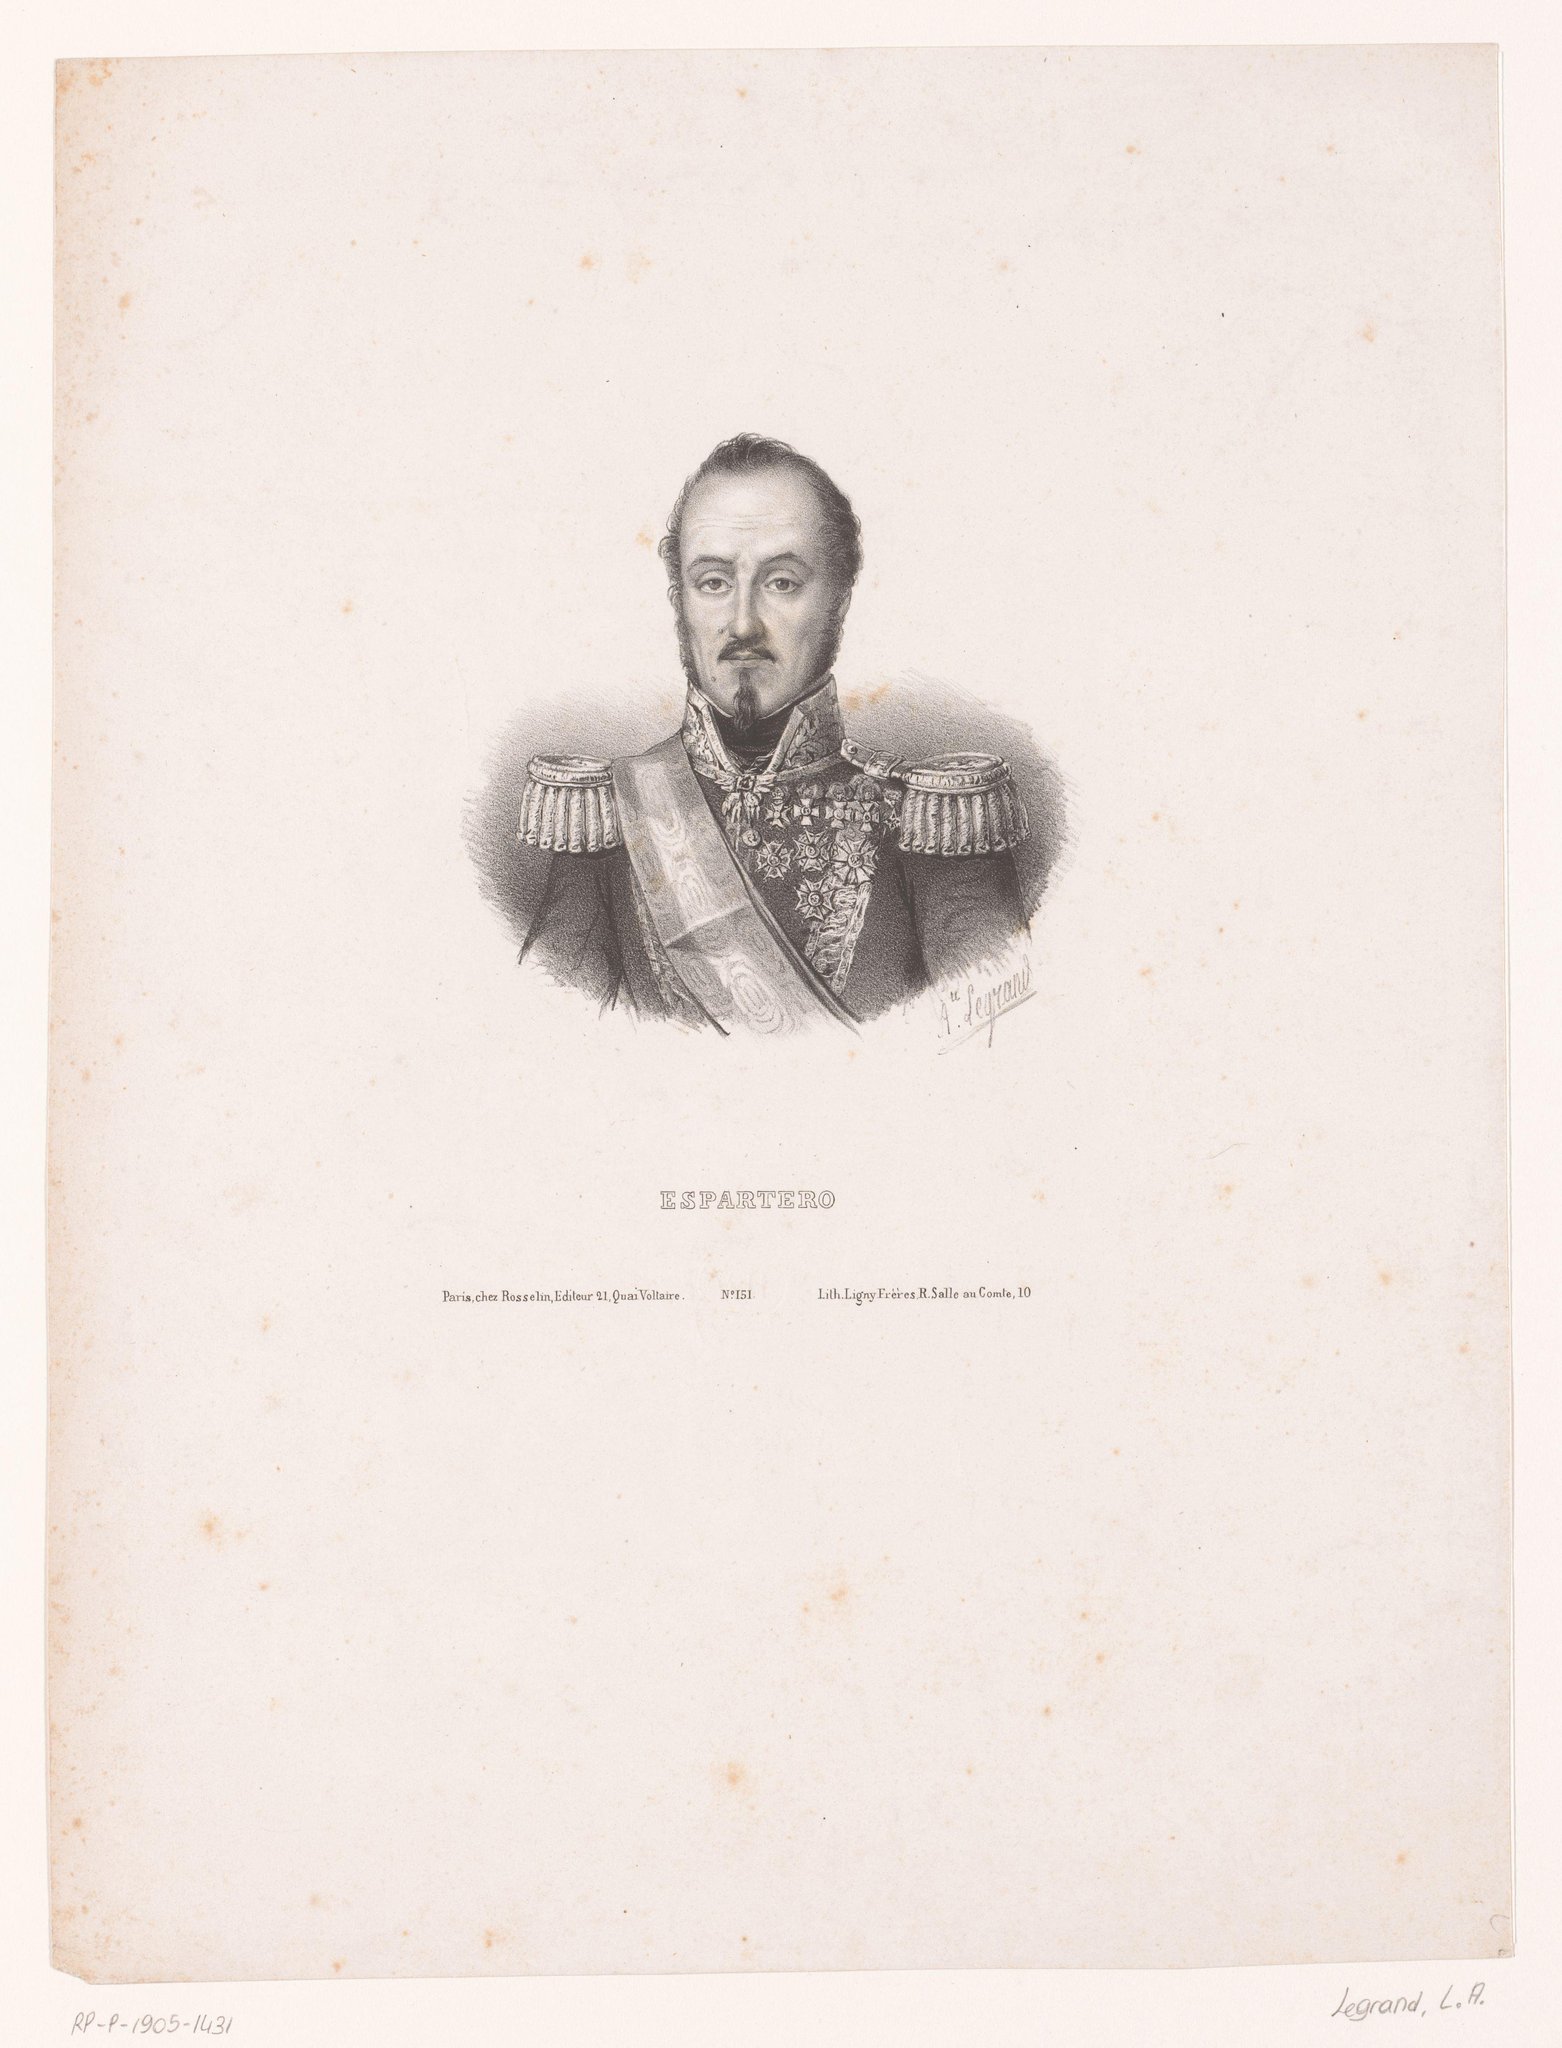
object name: print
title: Portret van Baldomero Espartero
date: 1840-1844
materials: paper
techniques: lithograph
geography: paris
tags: politician, historical persons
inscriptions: check stamp: Lugt 3693, collector's mark: Lugt 2228a